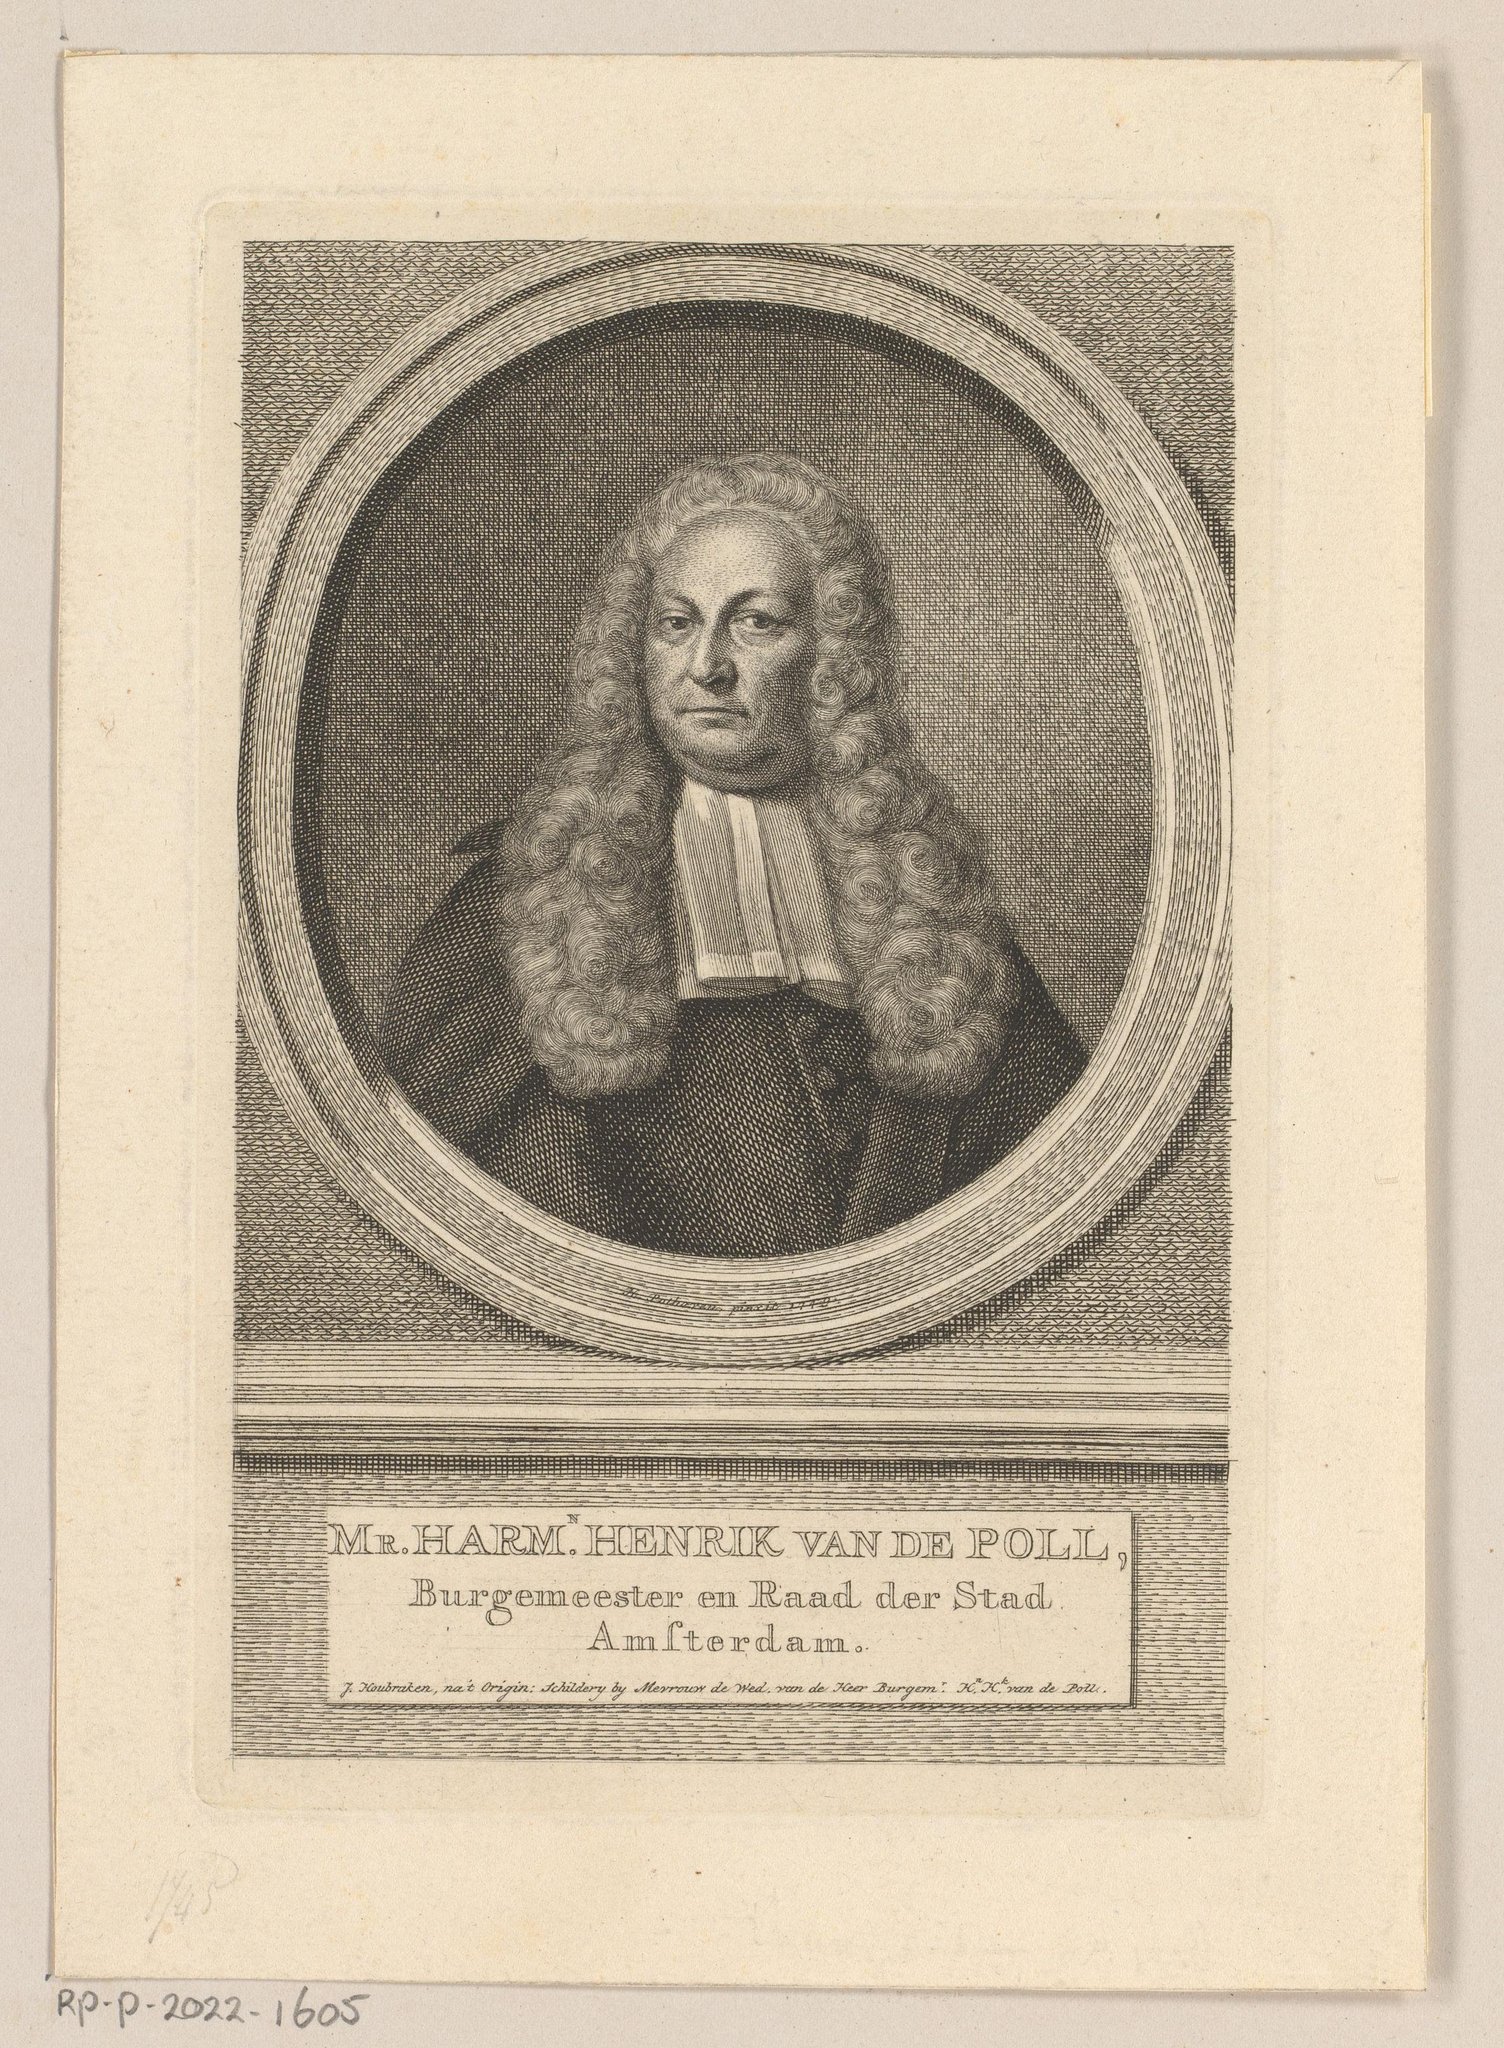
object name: print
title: Portret van Harmen Henrik van de Poll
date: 1768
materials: paper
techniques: engraving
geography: amsterdam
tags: mayor, mayor, burgomaster, historical persons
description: Prent waarschijnlijk uit: Wagenaar, Jacob, Jacobus Buys, Jacob Houbraken, Cornelis Ploos van Amstel en Reinier Vinkeles. Amsterdam in zyne opkomst, aanwas, geschiedenissen, voorregten, koophandel, gebouwen, kerkenstaat, schoolen, schutterye, gilden en regeeringe. Amsterdam: Isaak Tirion, 1768, dl. 12.